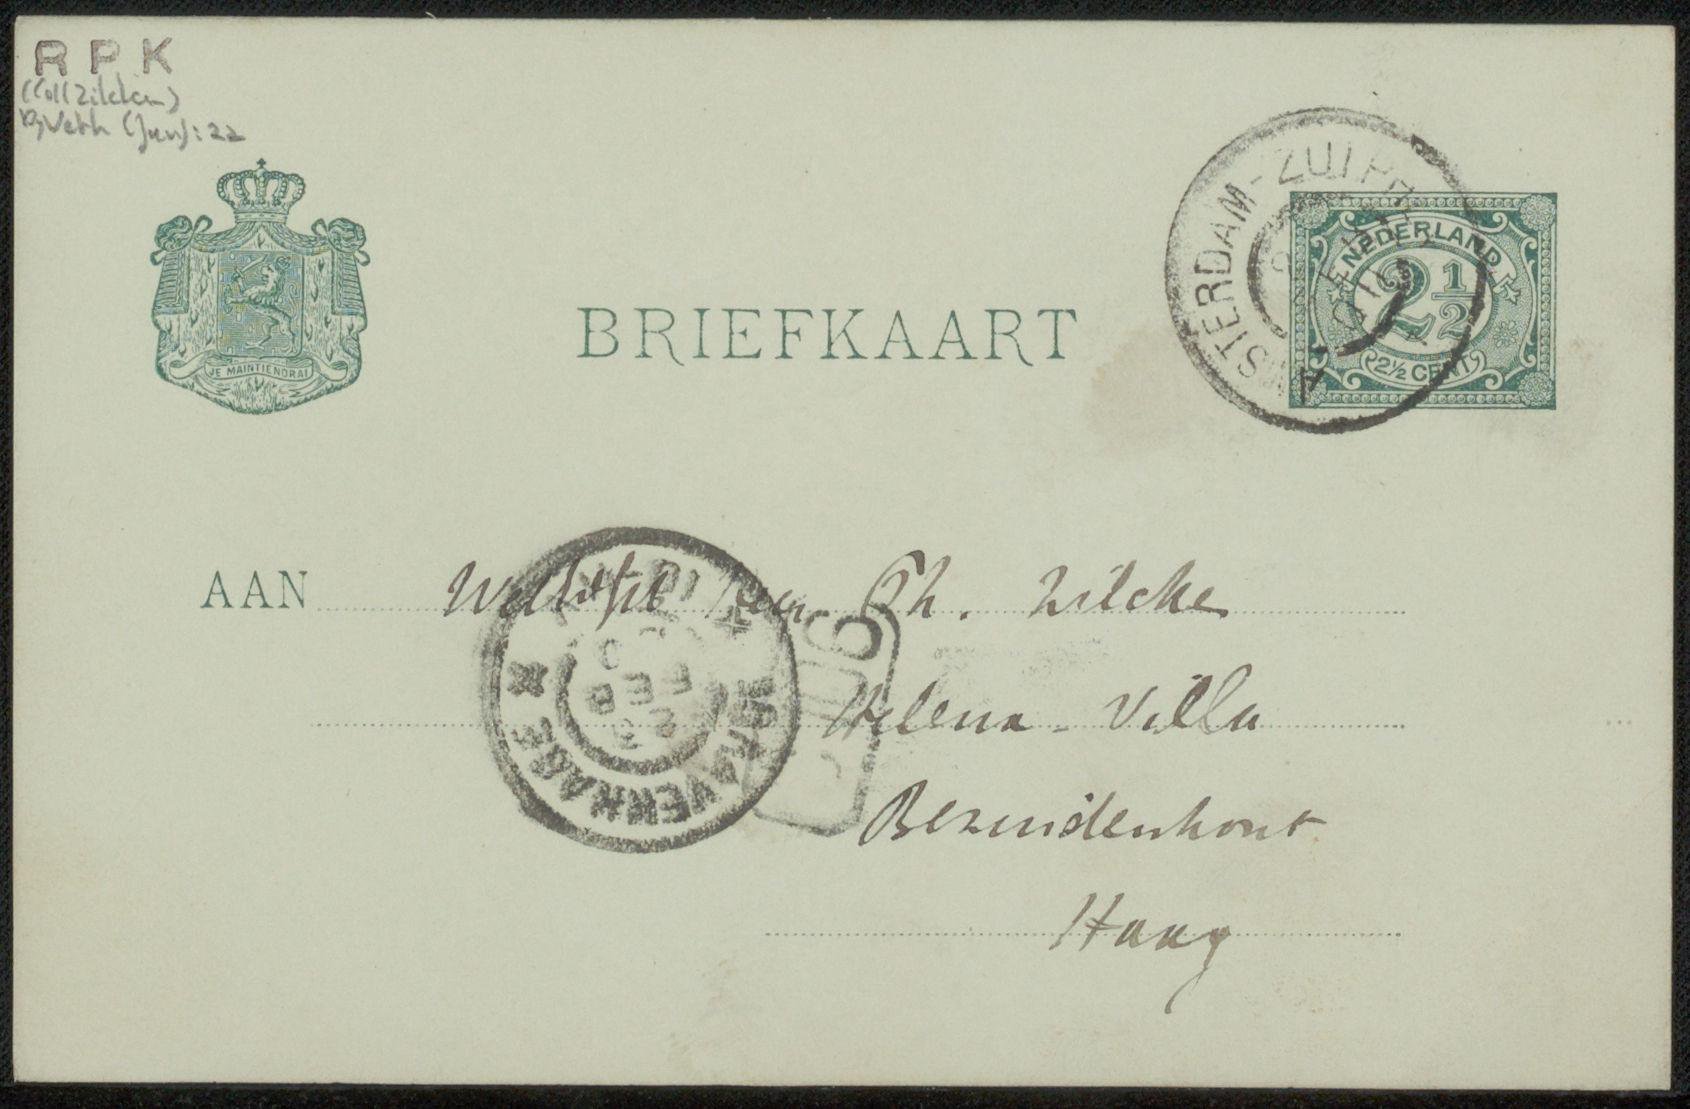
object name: postcard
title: Briefkaart aan Philip Zilcken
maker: jan veth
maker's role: designer, draughtsman, painter, print maker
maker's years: 1864-1925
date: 1900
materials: cardboard, ink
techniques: pen, writing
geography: bussum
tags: abraham kuyper, the hague, painter, draughtsman, philip zilcken, the graphic arts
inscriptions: collector's mark: ‘RPK’